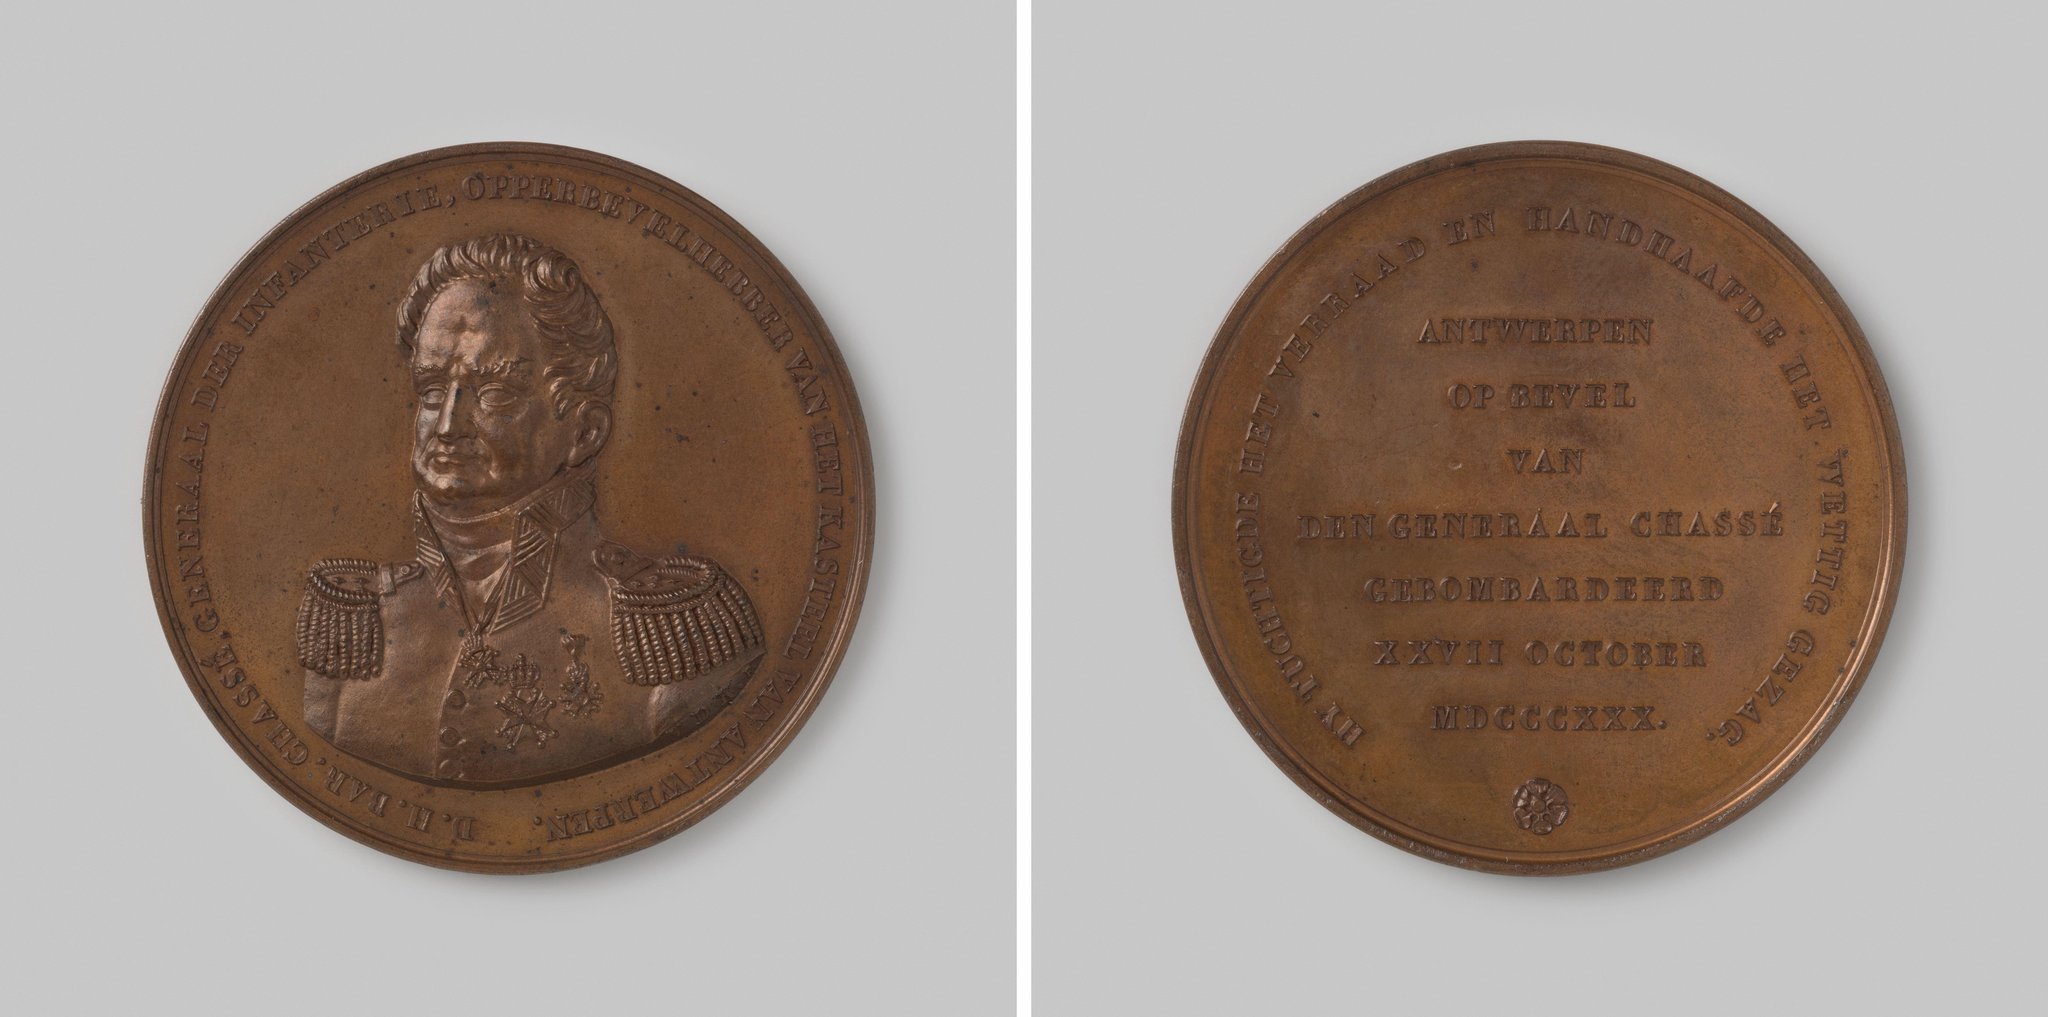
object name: history medal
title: Bombardement van Antwerpen door Generaal Chassé 1830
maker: david van der kellen (1804-1879)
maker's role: die cutter, draughtsman, print maker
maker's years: 1804-1879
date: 1830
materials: bronze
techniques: striking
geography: utrecht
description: Bronzen penning, op de voorzijde het borstbeeld van Chassé half naar links met omschrift, op de keerzijde zeven regels tekst met omschrift.